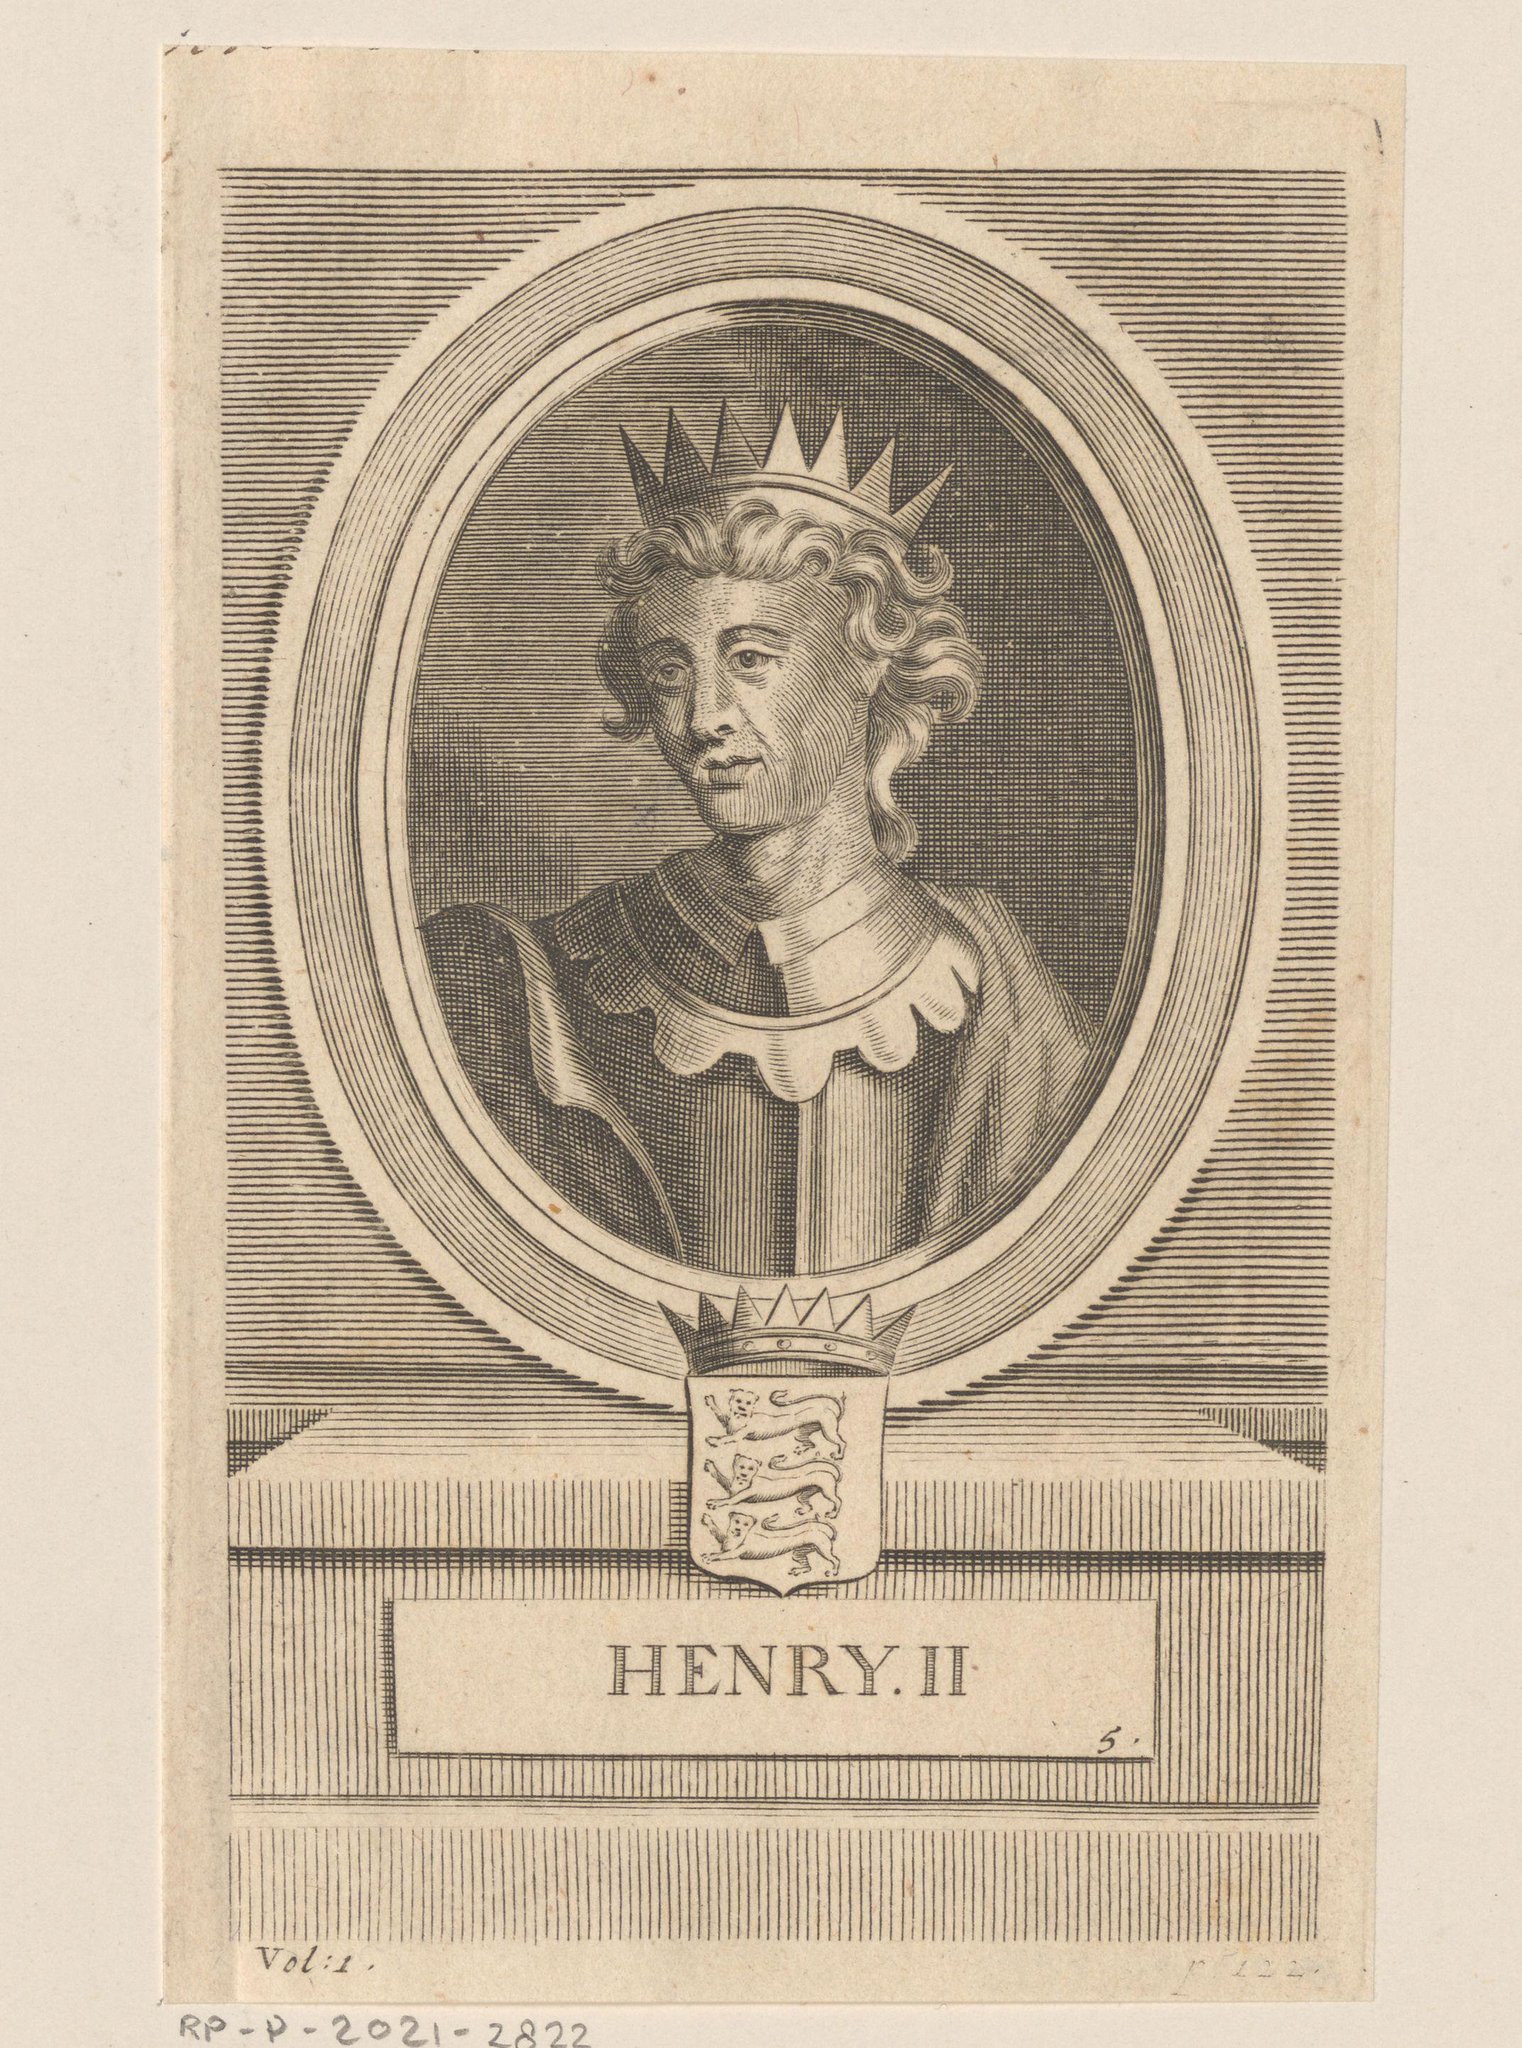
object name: print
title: Portret van Hendrik II, koning van Engeland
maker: Anonymous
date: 1700-1749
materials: paper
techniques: engraving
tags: historical persons, king, armorial bearing, heraldry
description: Prent gebruikt in: The history of England. Faithfully extracted from authentick records (…). Londen: Isaac Cleaver, 1715, dl. 1. Prent mogelijk ook gebruikt in andere edities van dit werk of andere publicaties.